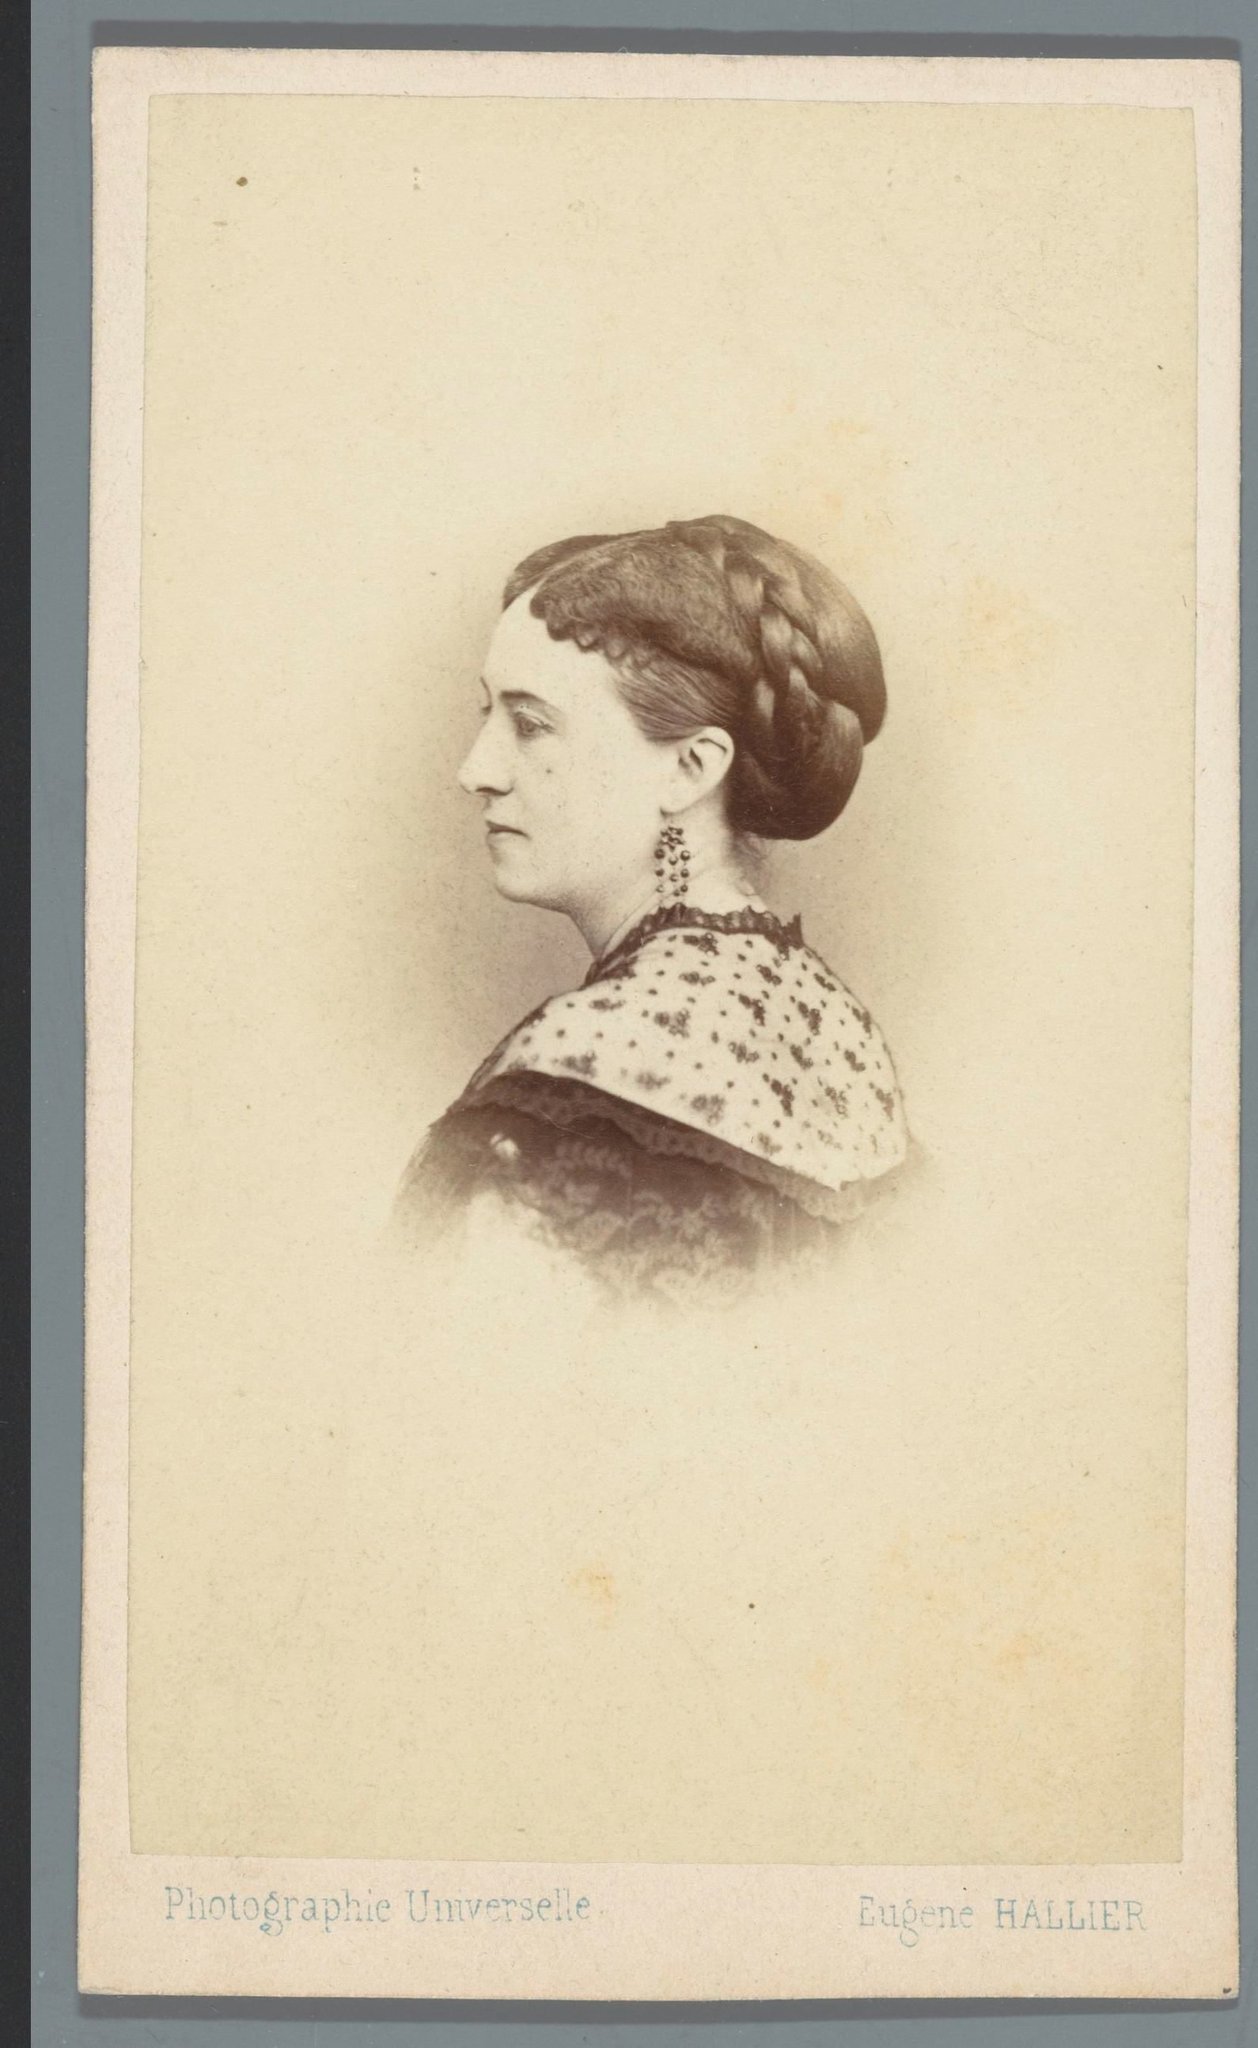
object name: photograph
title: Portret van Mme Gaveau-Sabatier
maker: eugène hallier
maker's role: fotograaf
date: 1864-1871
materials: cardboard, paper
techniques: albumen print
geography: paris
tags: adult woman, historical persons, paris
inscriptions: inscription: ‘Photographie universelle/ Eugène Hallier/ 17, Rue de Grammont./ Paris’, inscription: ‘Photographie Universelle. Eugene Hallier’, inscription: ‘Mme Gaveau-Sabatier’